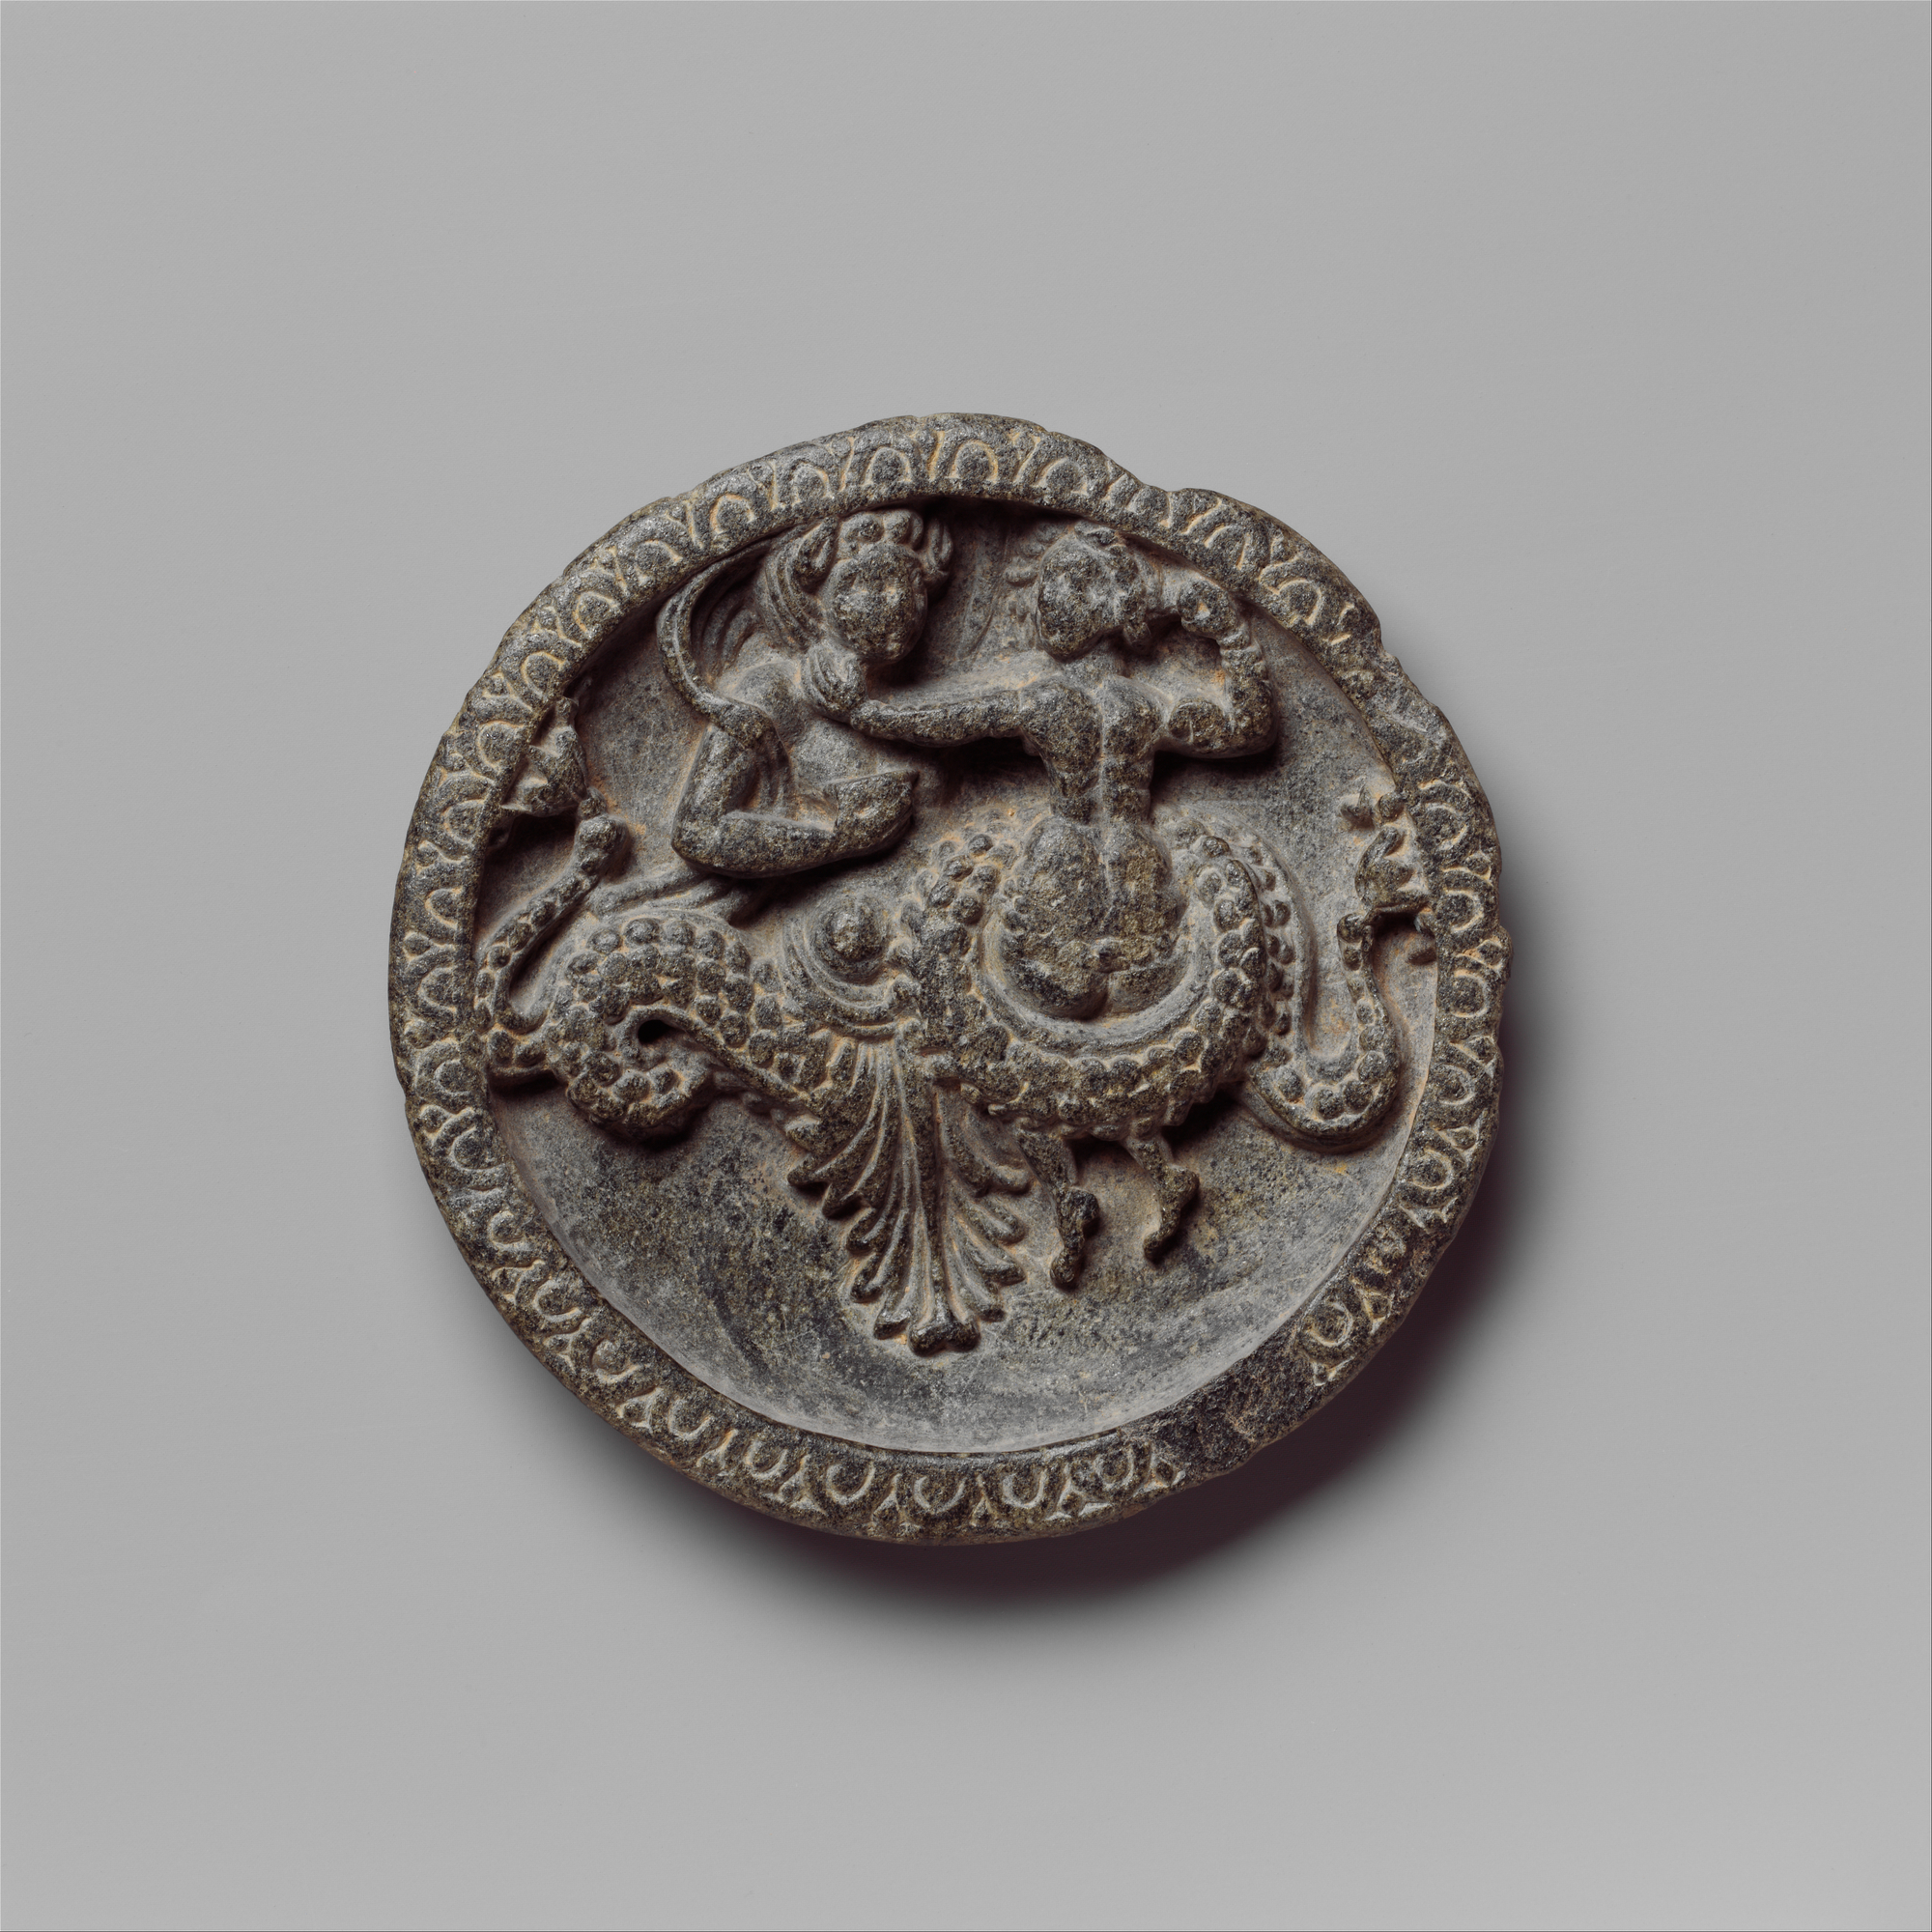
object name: dish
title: Dish with Marine Creature and Couple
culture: gandhara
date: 100-1 BCE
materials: stone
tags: human figures,gandhara